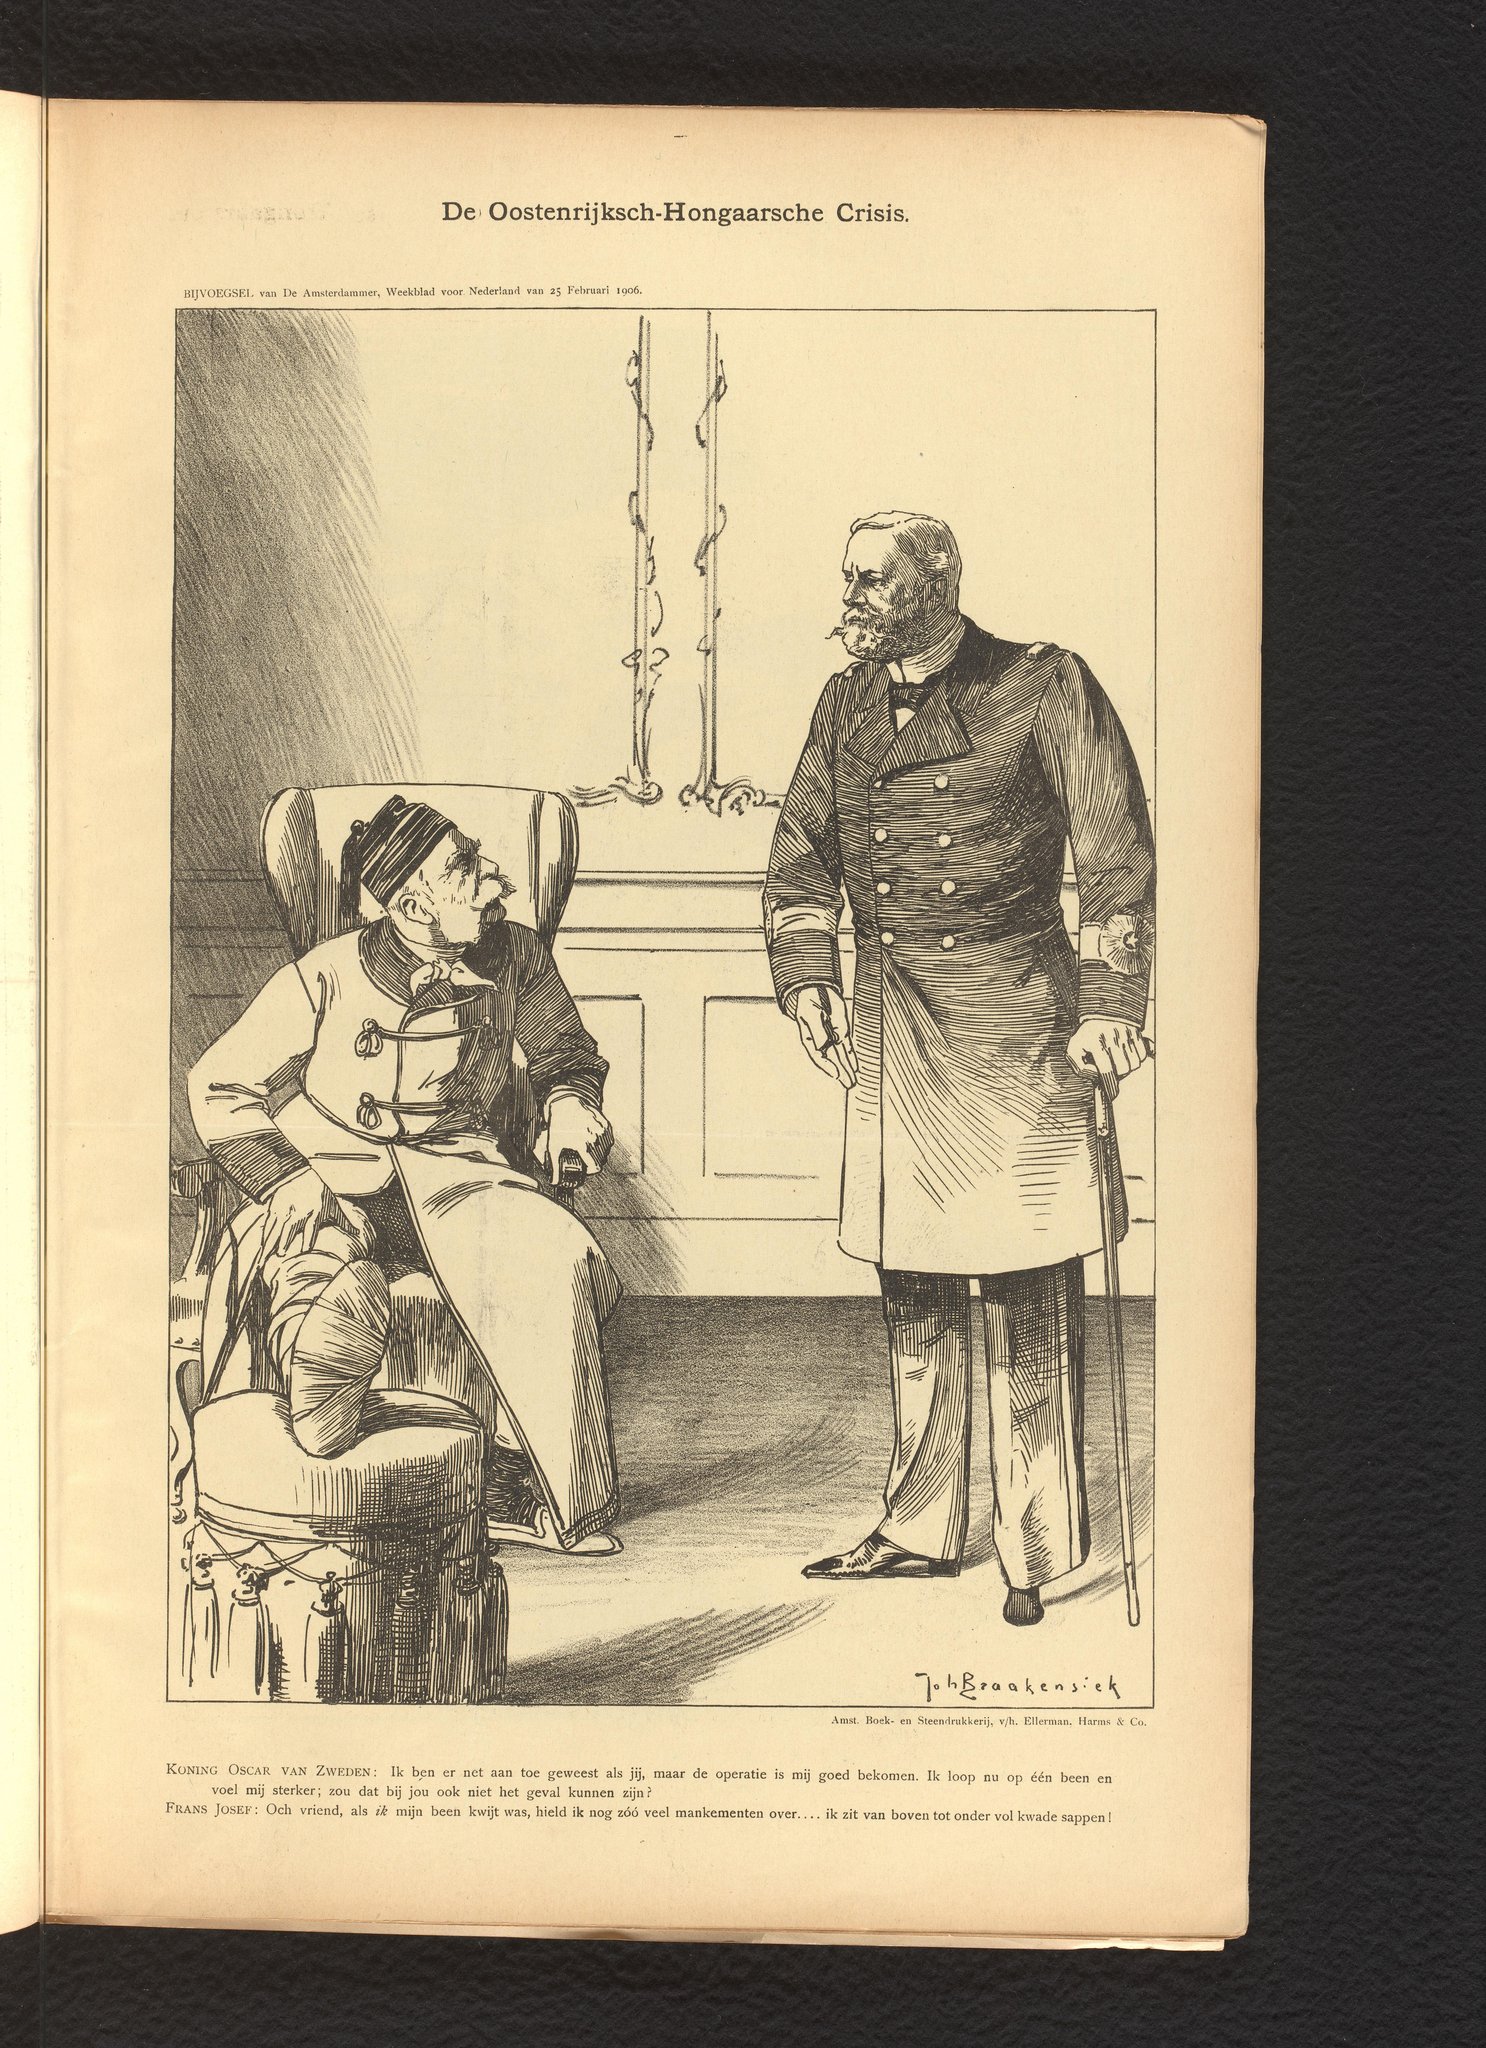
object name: cartoon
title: De Oostenrijksch-Hongaarsche Crisis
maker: johan braakensiek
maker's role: draughtsman, print maker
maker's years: 1858-1940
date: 1906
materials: paper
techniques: lithograph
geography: netherlands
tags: vienna, wooden leg, visiting the sick; sick person together with others, political caricatures and satires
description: De Zweedse koning Oscar II op ziekenbezoek bij de Oostenrijke keizer Frans Jozef I die met een voet in het verband zit. Oscar heeft net een voet laten afzetten (het verlies van Noorwegen) en loopt op één been maar voelt zich beter dan ooit.